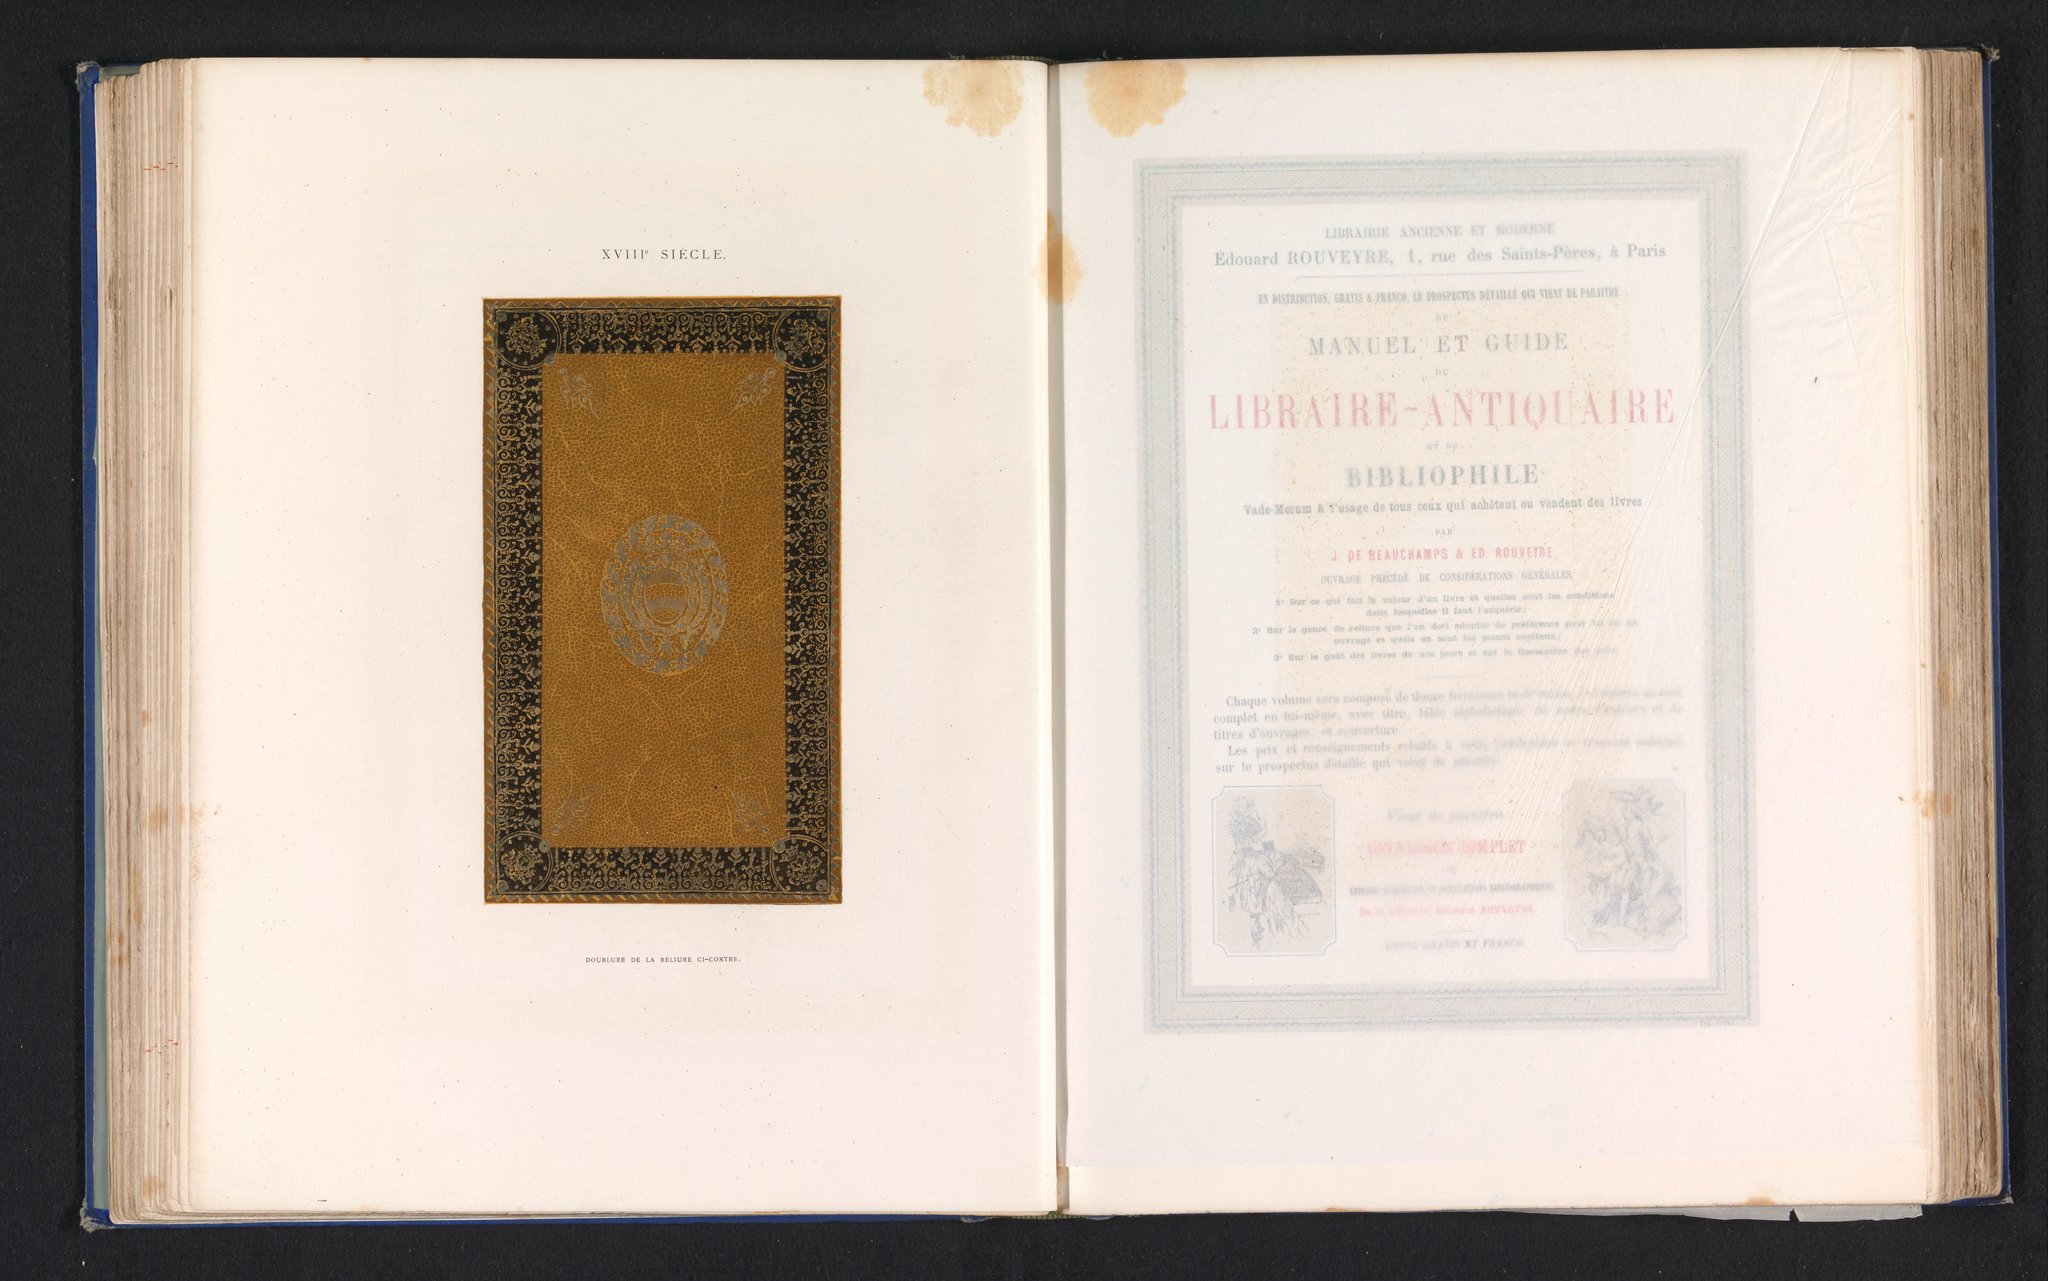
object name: page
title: Omslag van een boek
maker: Anonymous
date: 1871-1881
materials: paper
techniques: printing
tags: book-cover, binding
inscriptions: inscription: ‘XVIIIe siècle doublure de la reliure ci-contre.’